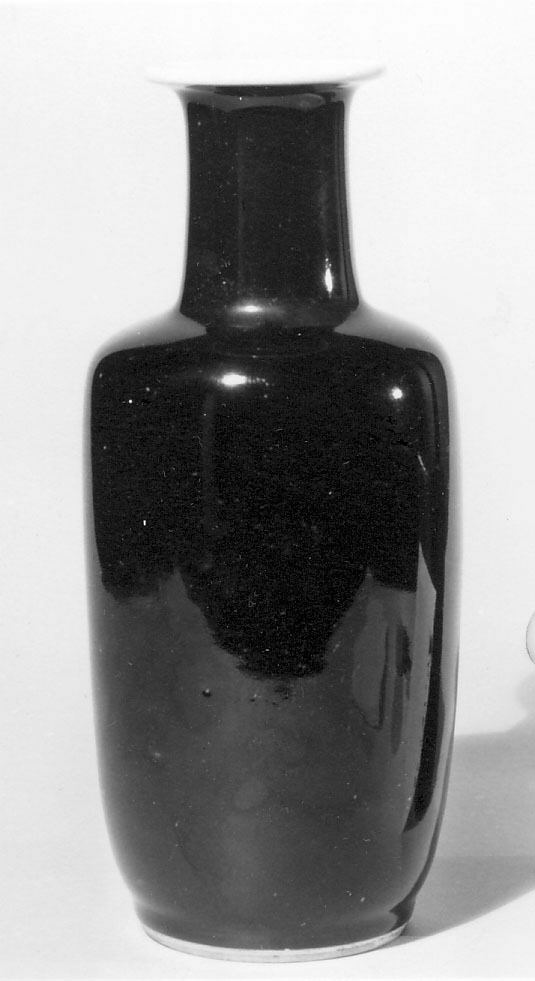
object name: vase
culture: chinese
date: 1662-1722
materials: porcelain